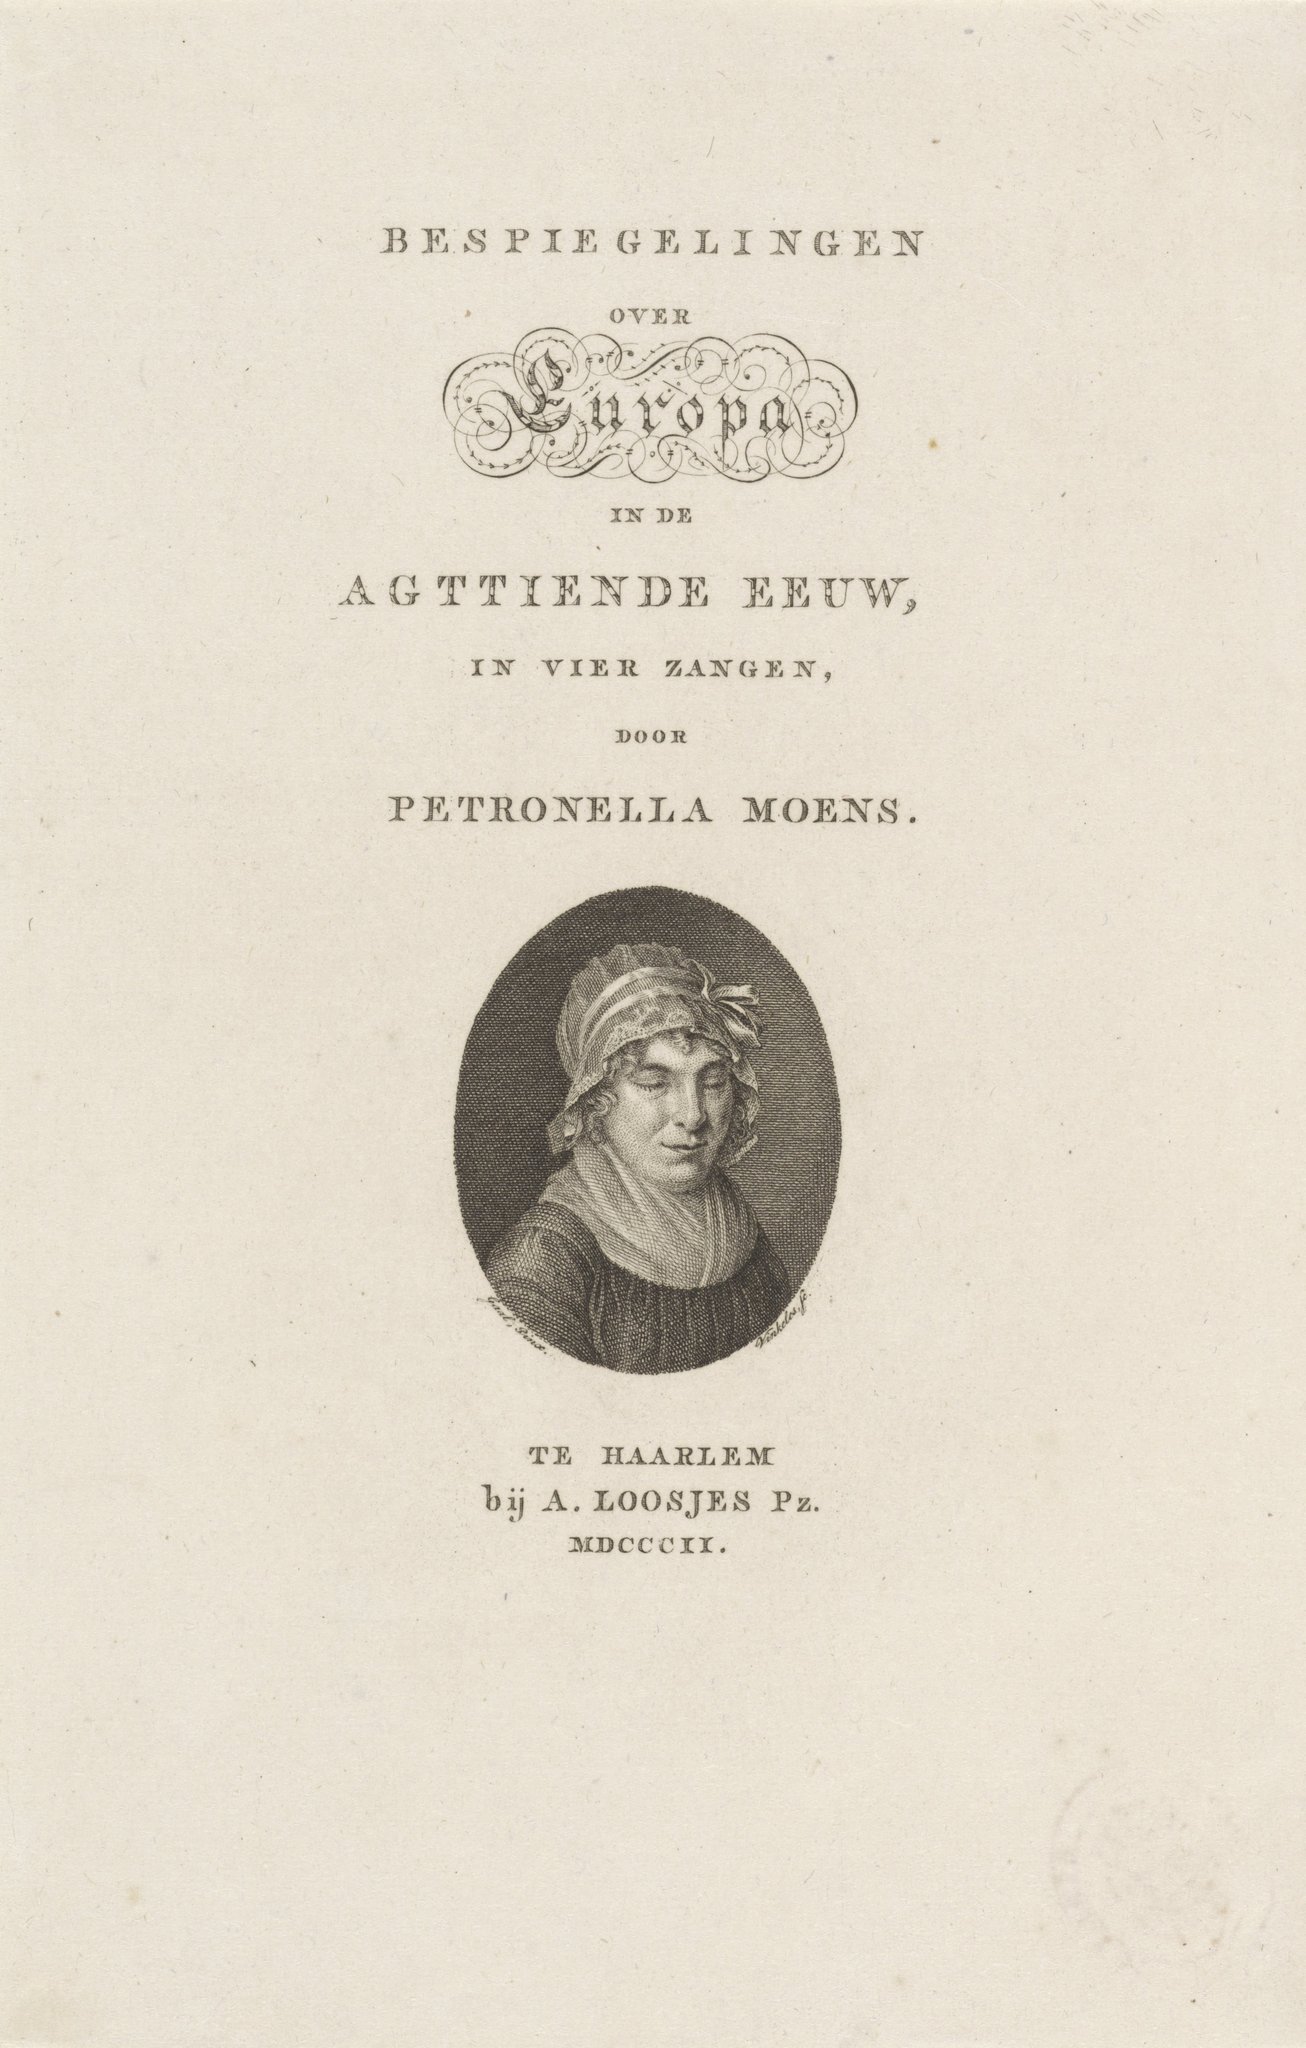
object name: titelblad, titelpagina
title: Portret van Nederlandse dichteres Petronella Moens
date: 1802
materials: paper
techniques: engraving, etching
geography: haarlem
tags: utrecht, petronella moens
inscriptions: collector's mark: Lugt 240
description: Prent gebruikt als titelpagina voor: Moens, Petronella. Bespiegelingen over Europa, in de agttiende eeuw, in vier zangen. Haarlem: Adriaan Pietersz. Loosjes, 1802.